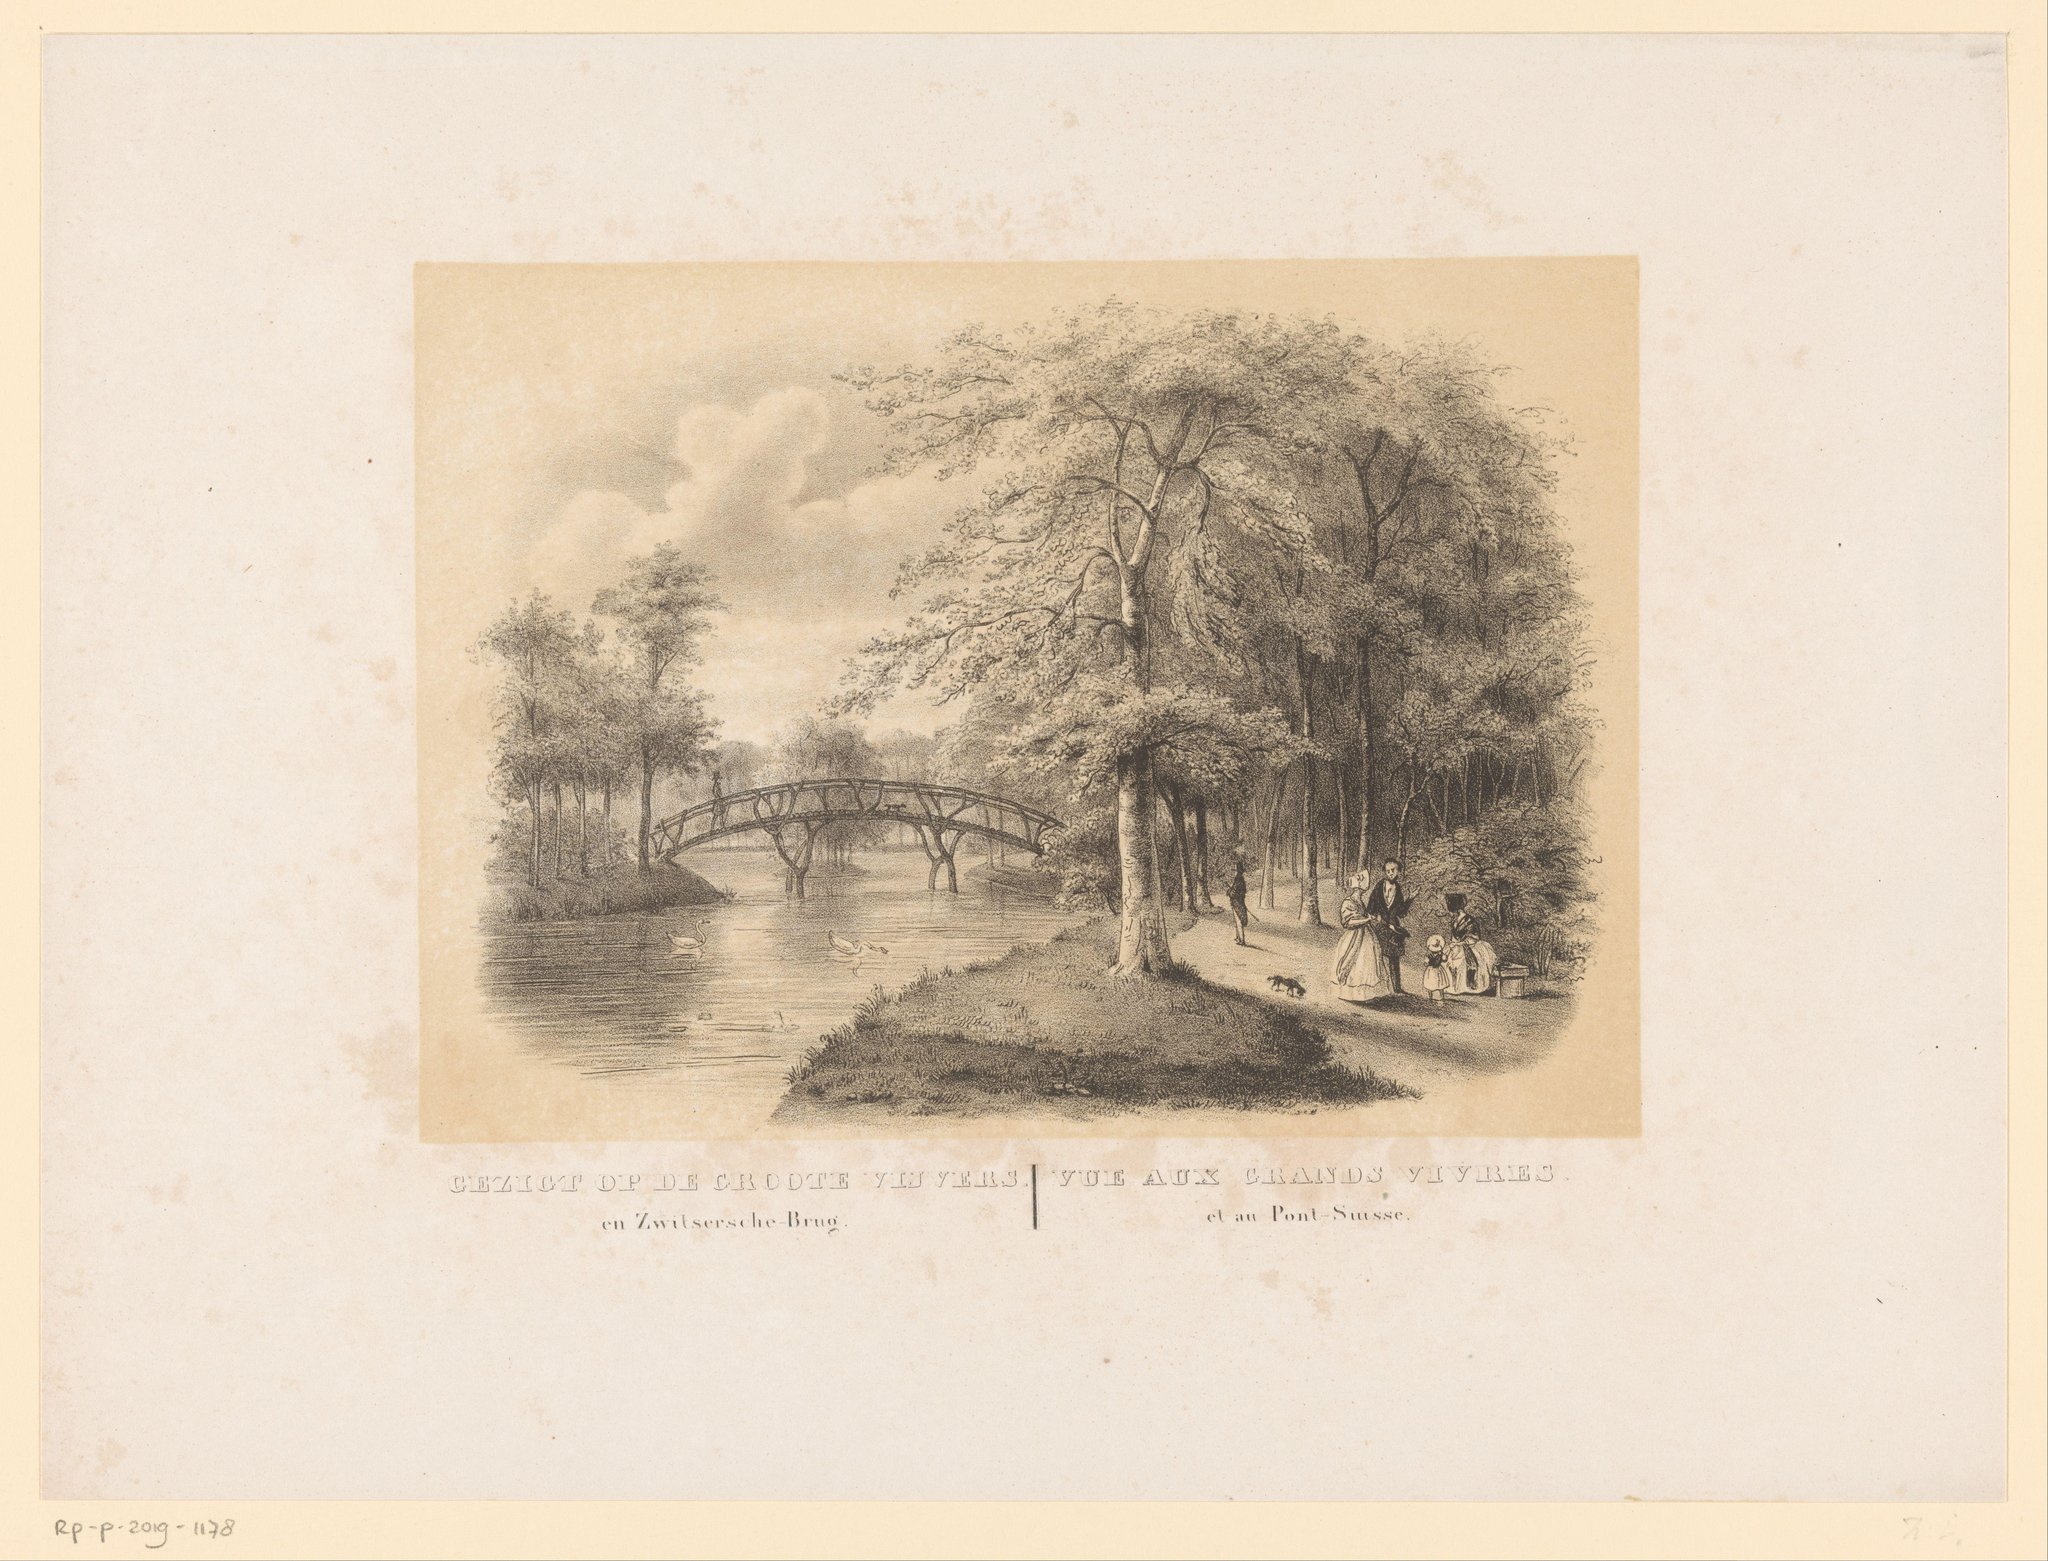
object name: print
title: Gezigt op de groote vijvers in Zwitsersche-Brug / Vue aux grands vivres et au Pont-Suisse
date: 1830-1846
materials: paper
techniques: tone lithography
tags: strolling, bridge, wood and park (as places of recreation), the hague